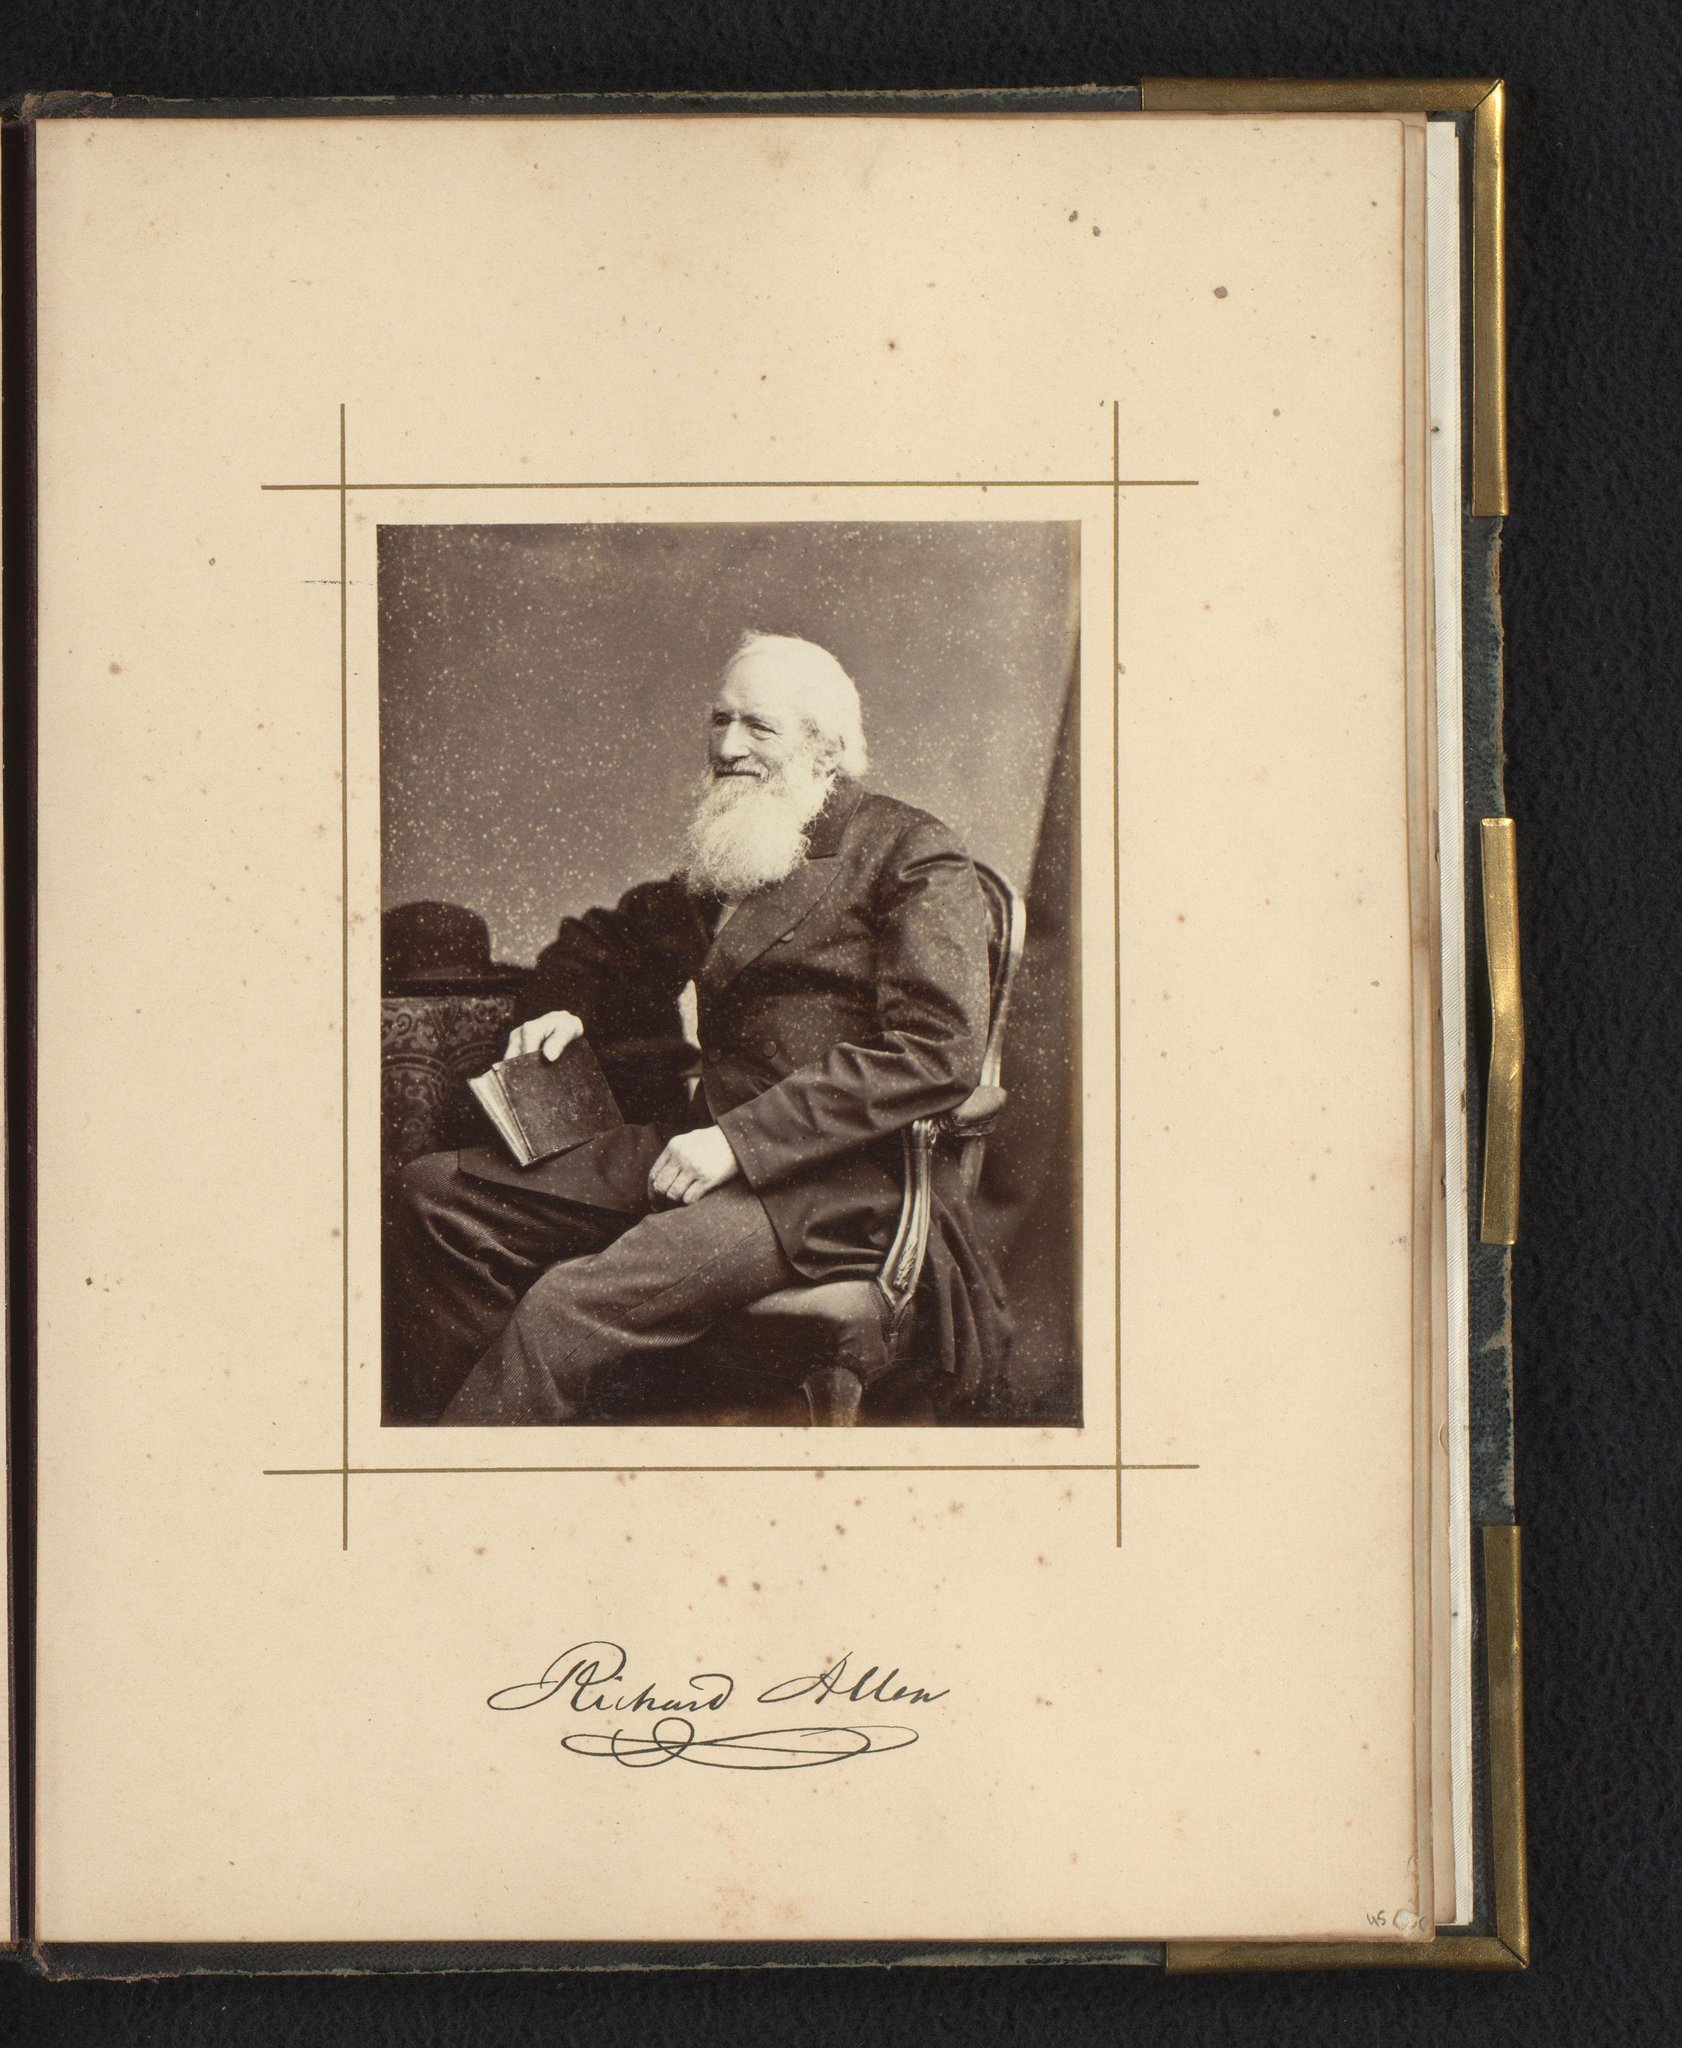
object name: photograph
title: Portret van Richard Allen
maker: Anonymous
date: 1866-1871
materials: photographic support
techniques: albumen print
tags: sitting figure, historical persons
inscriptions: name: ‘Richard Allen’